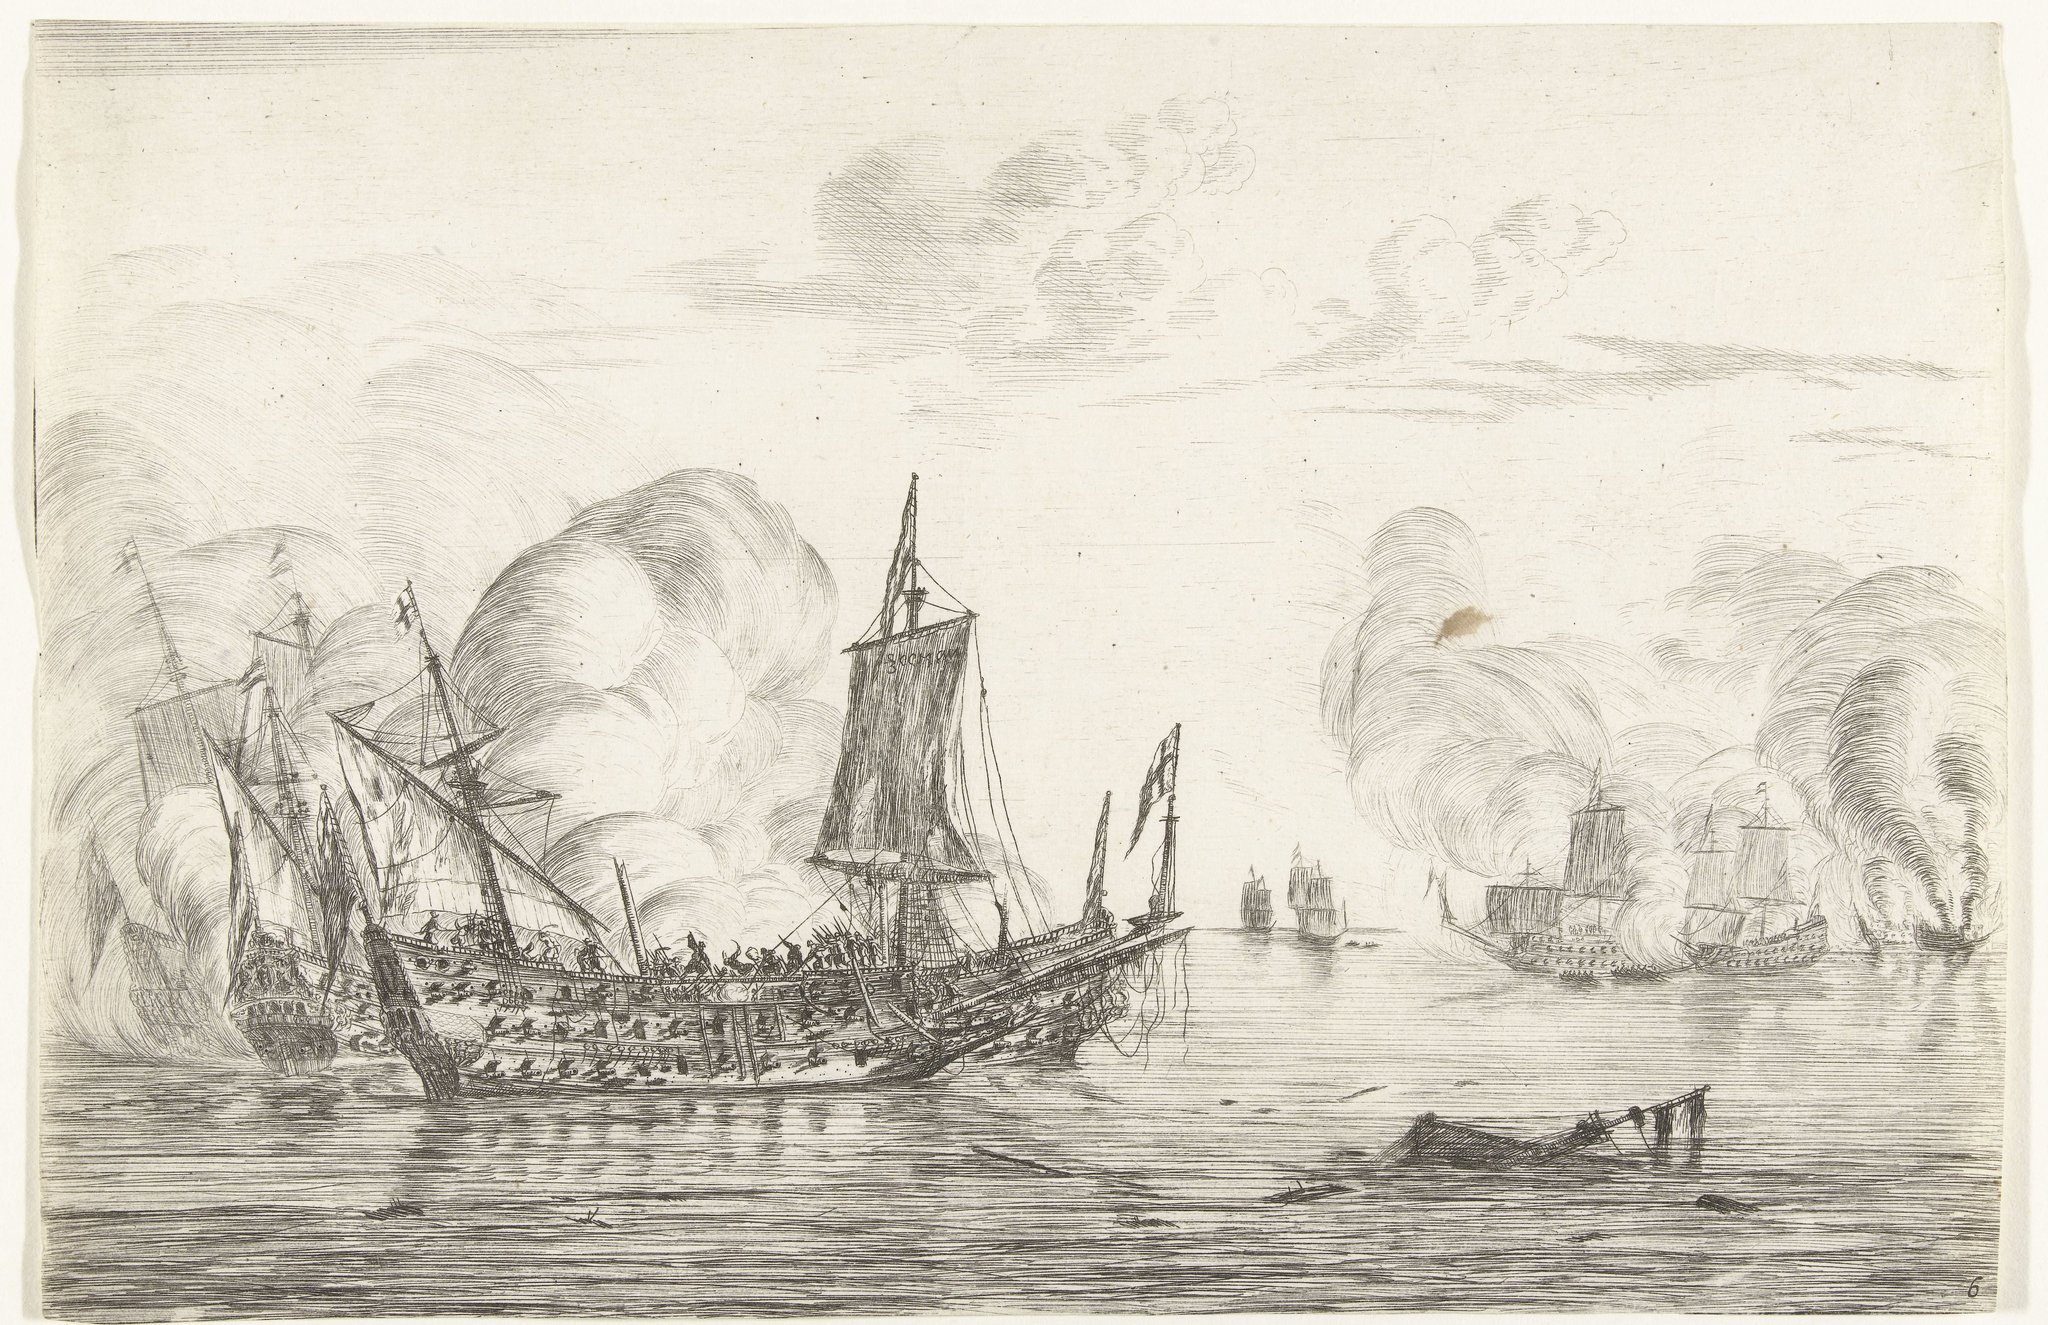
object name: print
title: Einde van een zeeslag, ca. 1652-1654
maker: reinier nooms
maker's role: draughtsman, painter, print maker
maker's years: 1623-1664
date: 1652-1654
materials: paper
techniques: drypoint, etching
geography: northern netherlands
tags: battle (+ naval force)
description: Engelse en Hollandse schepen tijdens het einde van een zeeslag. Centraal man-tegen-mangevechten op het dek van een zwaar gehavend Engels schip. Prent nr. 6 in een reeks van zeven genummerde platen van zeeslagen waarvan enkele gerelateerd kunnen worden aan de Eerste Engelse Oorlog van 1652-1654.